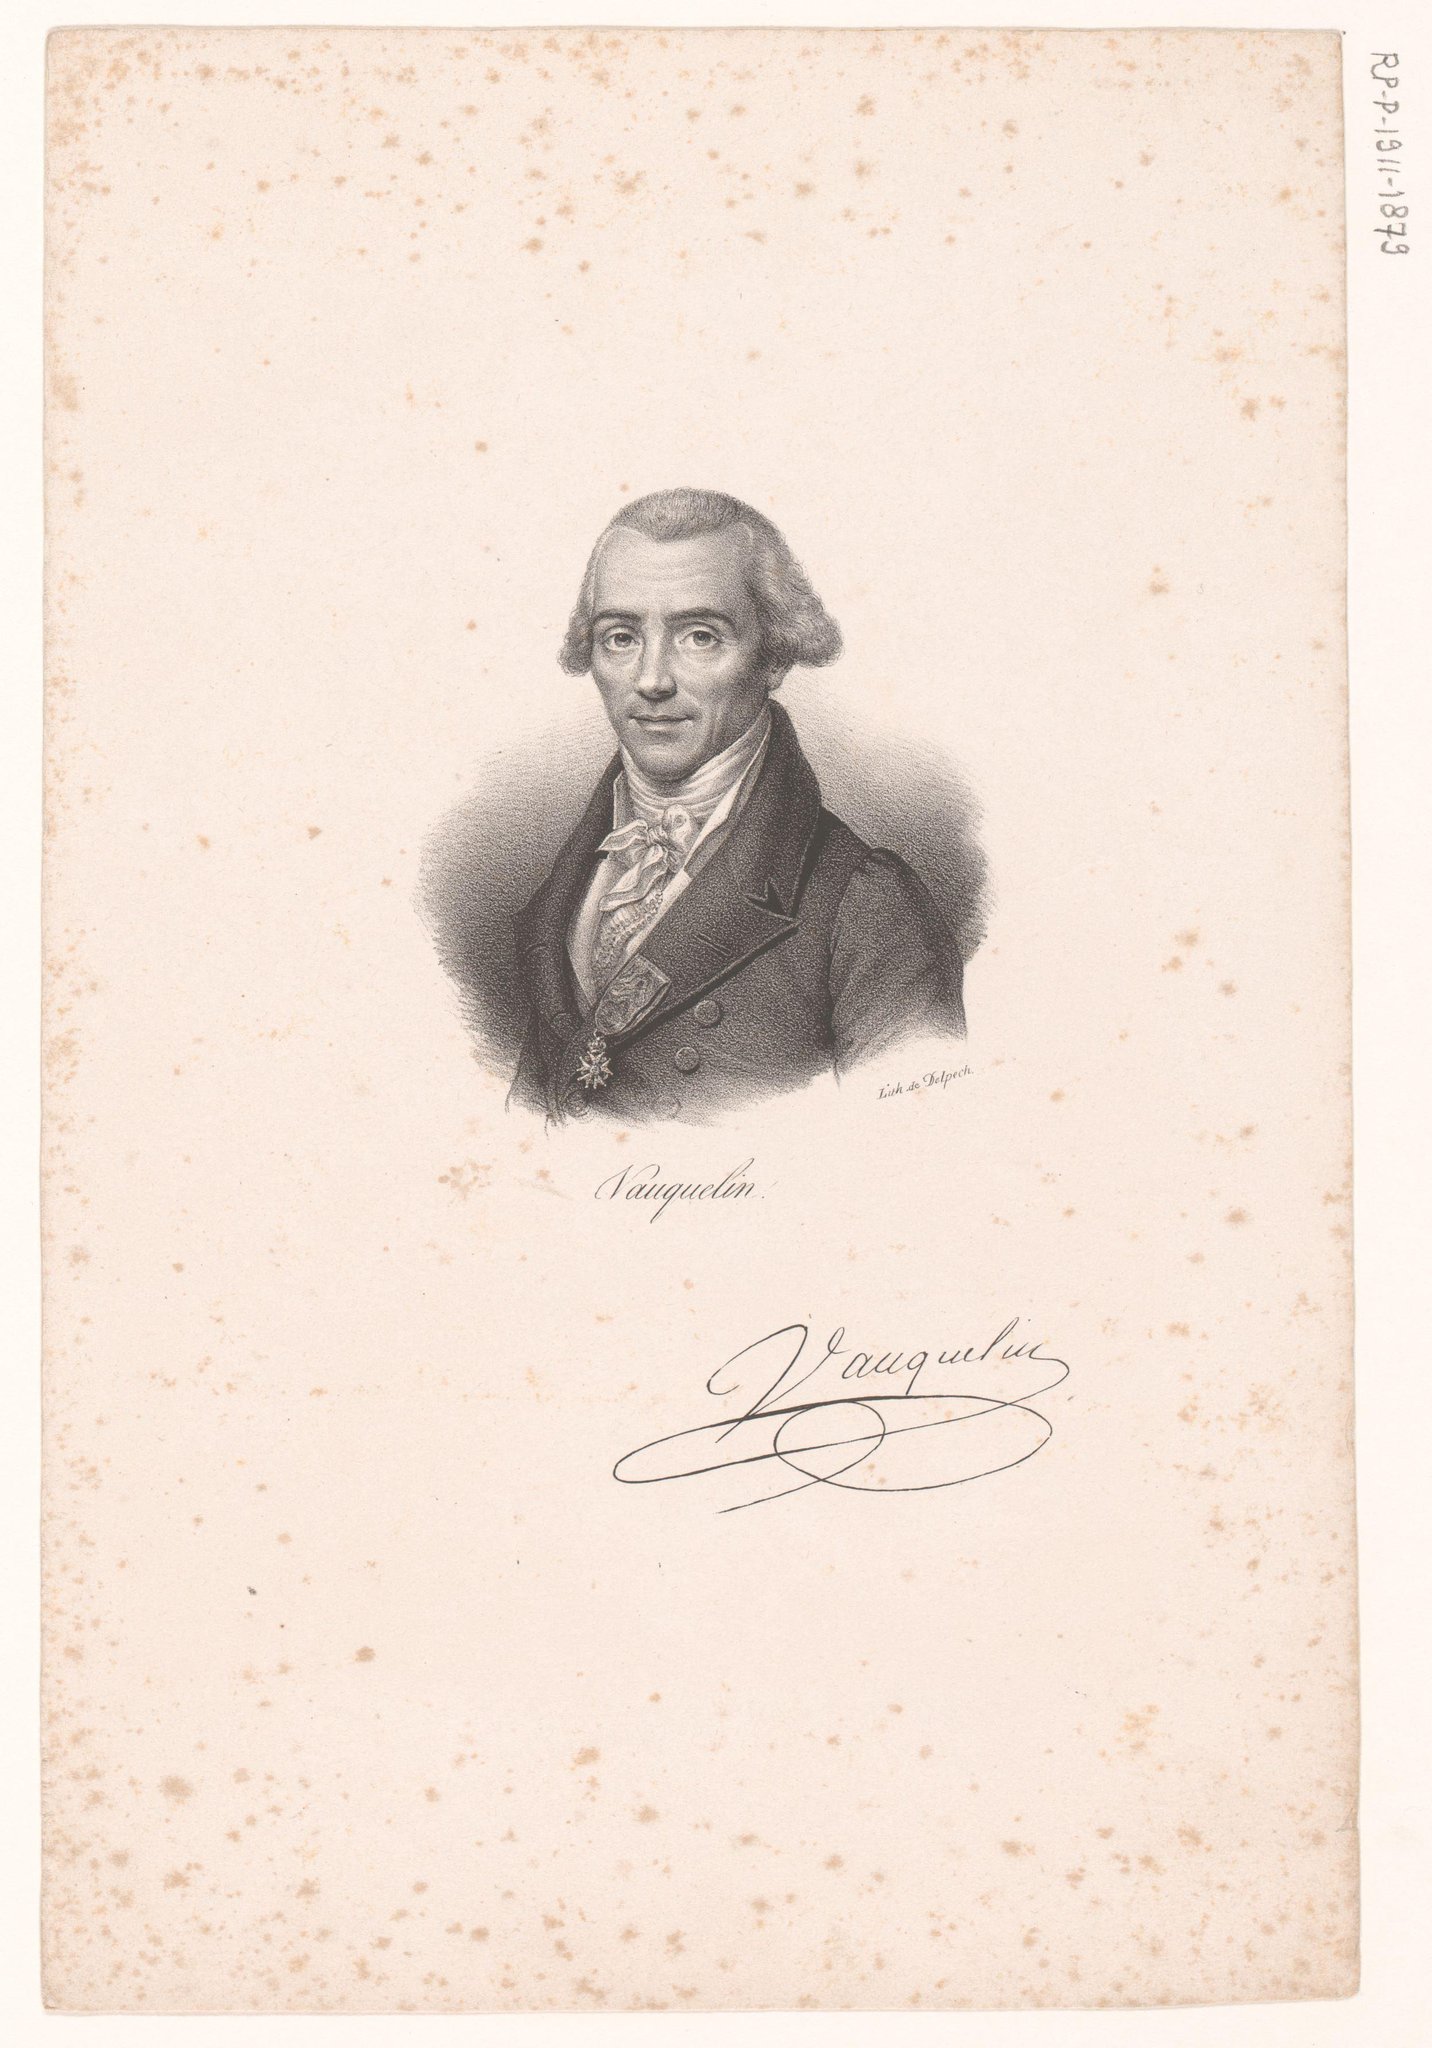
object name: print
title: Vauquelin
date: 1818-1842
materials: paper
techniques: lithograph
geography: paris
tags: historical persons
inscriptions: collector's mark: Lugt 2228a